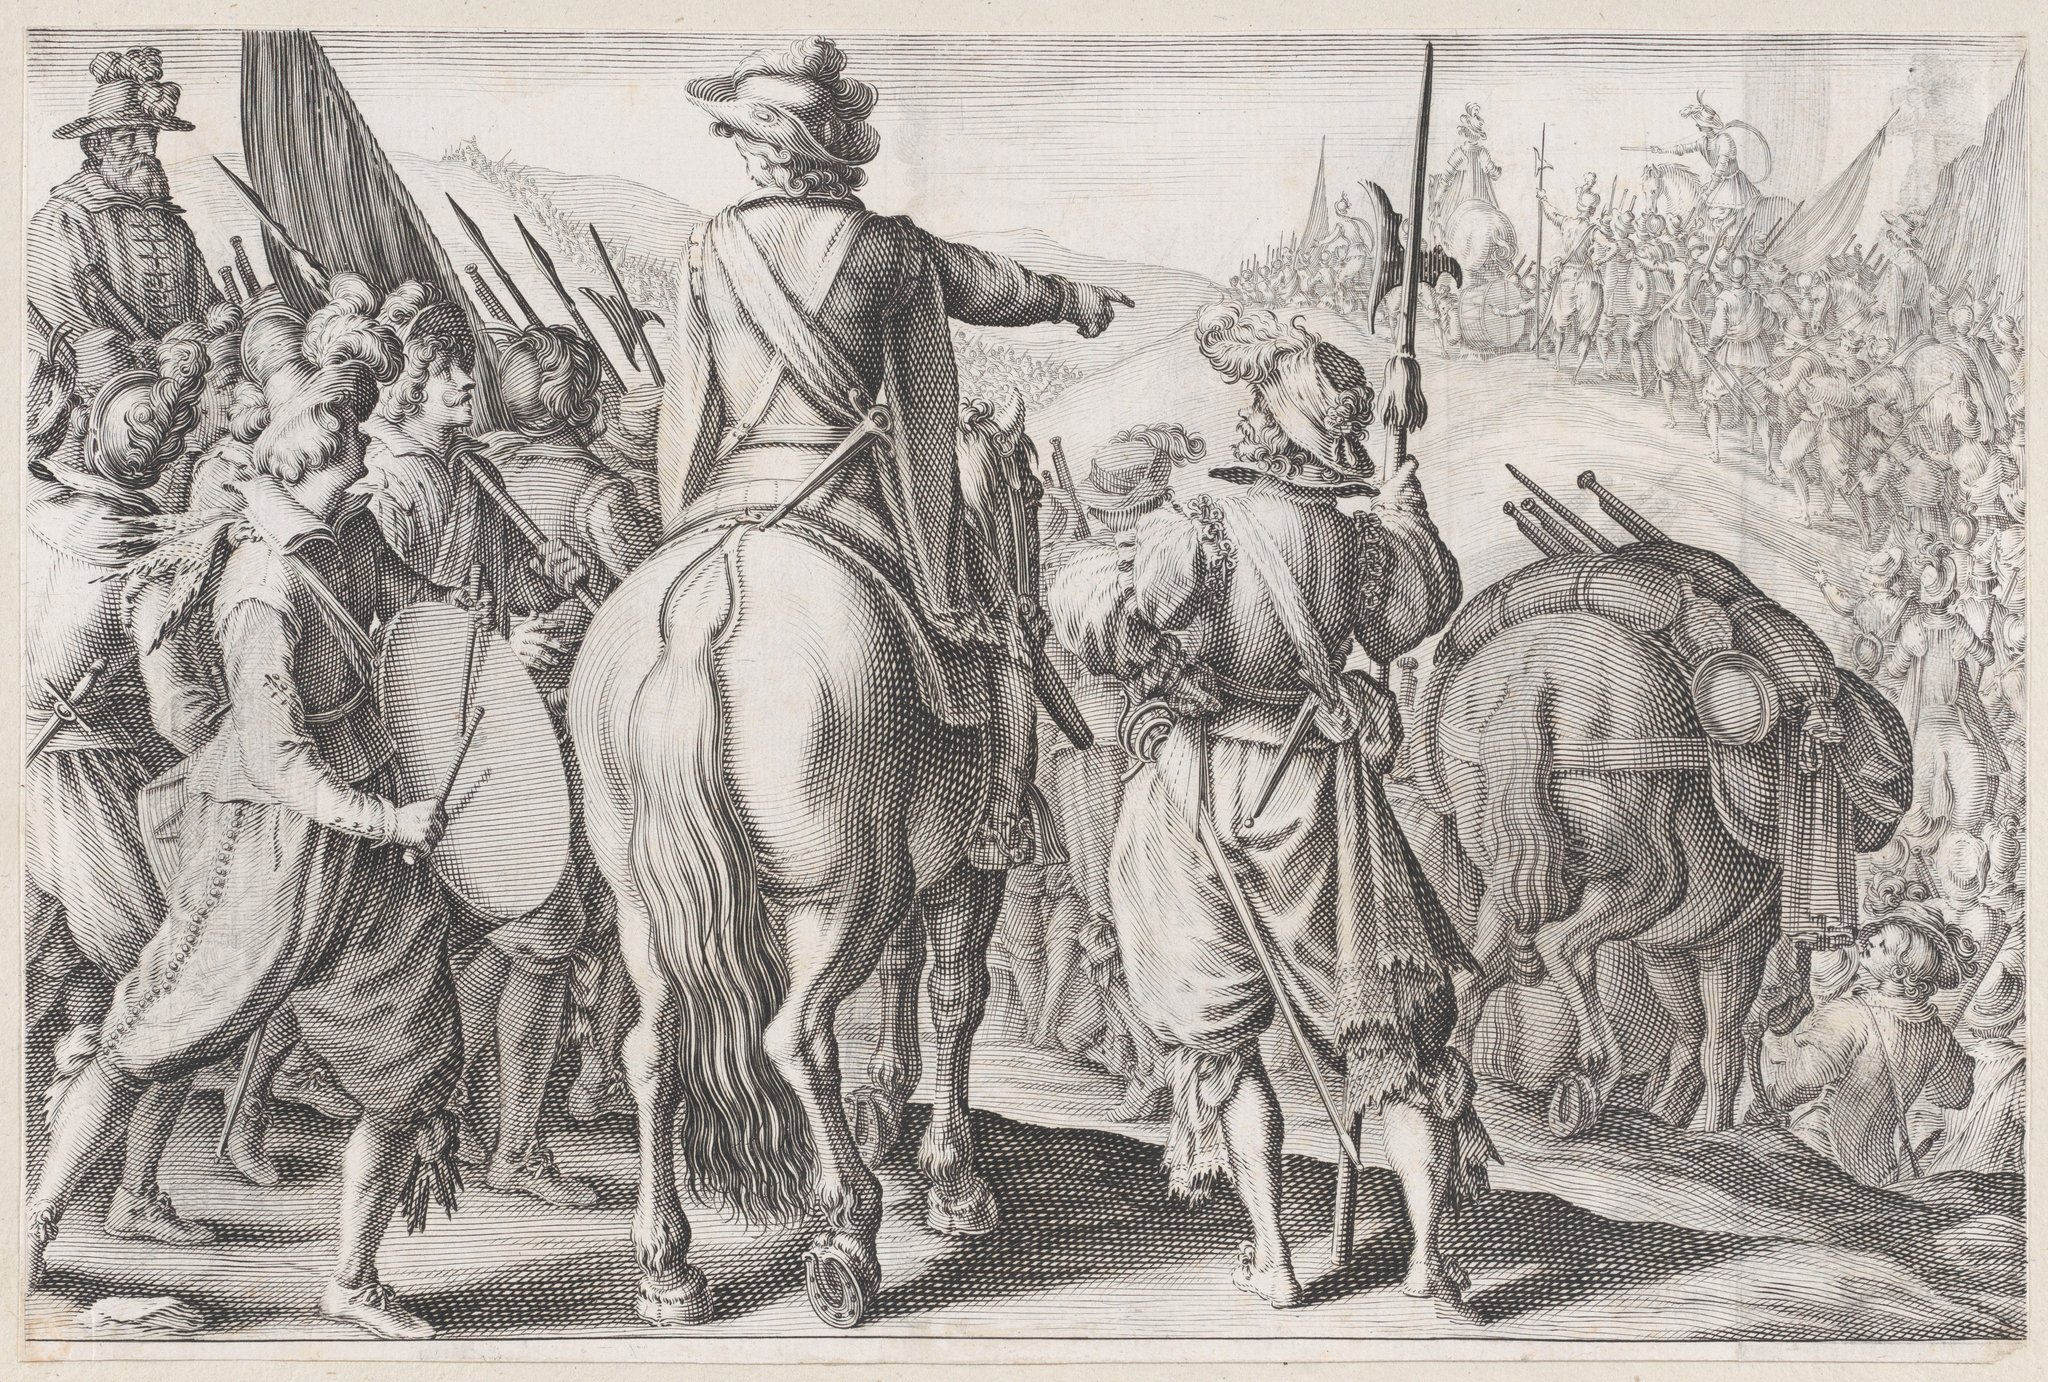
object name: print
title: Les Troupes en Marche (The Marching Troops), from "La Vie de Ferdinand Ier de Médicis série appelée aussi Les Batailles des Médicis" (The Life of Ferdinand I de'Medici also called The Medici Battles)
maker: jacques callot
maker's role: artist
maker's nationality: french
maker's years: 1592-1635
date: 1614-1620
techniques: engraving